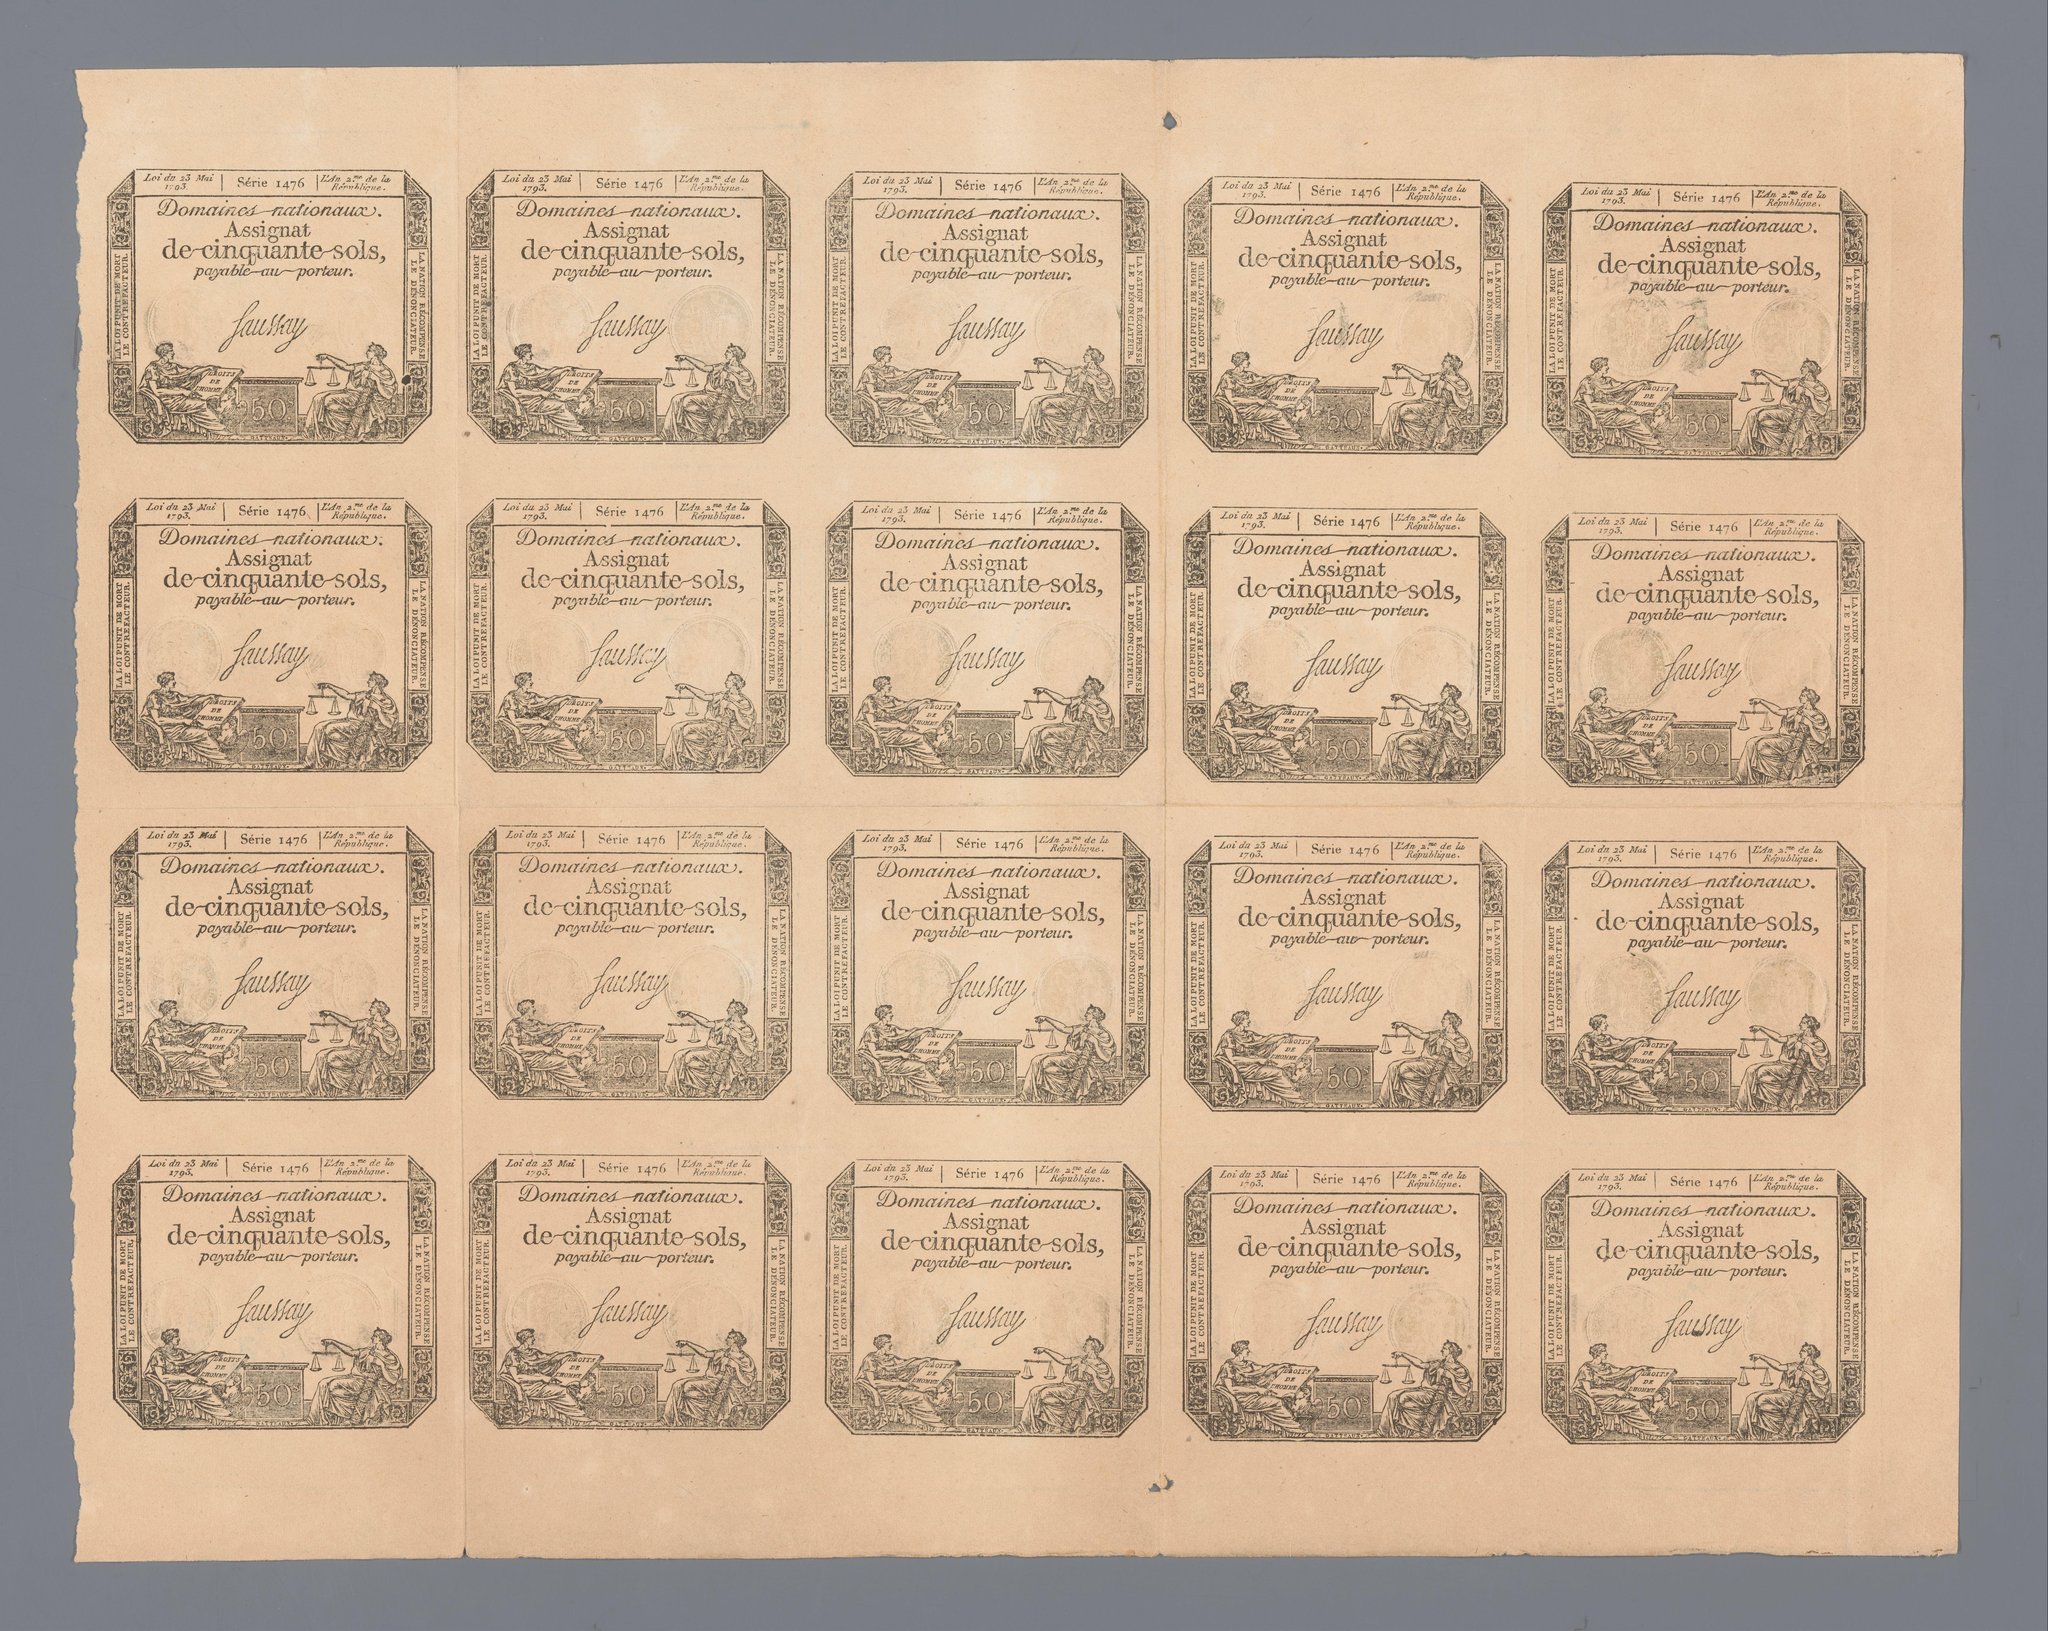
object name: assignat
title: Vel met 20 assignaten van vijftig sols, serie 1476 uitgegeven 23 mei 1793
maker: nicolas marie gatteaux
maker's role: medailleur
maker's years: 1751-1832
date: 1793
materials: paper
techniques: printing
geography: paris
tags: bank-note, france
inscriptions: signature: ‘Faussay’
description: Vel met 20 franse assignaten uit de serie 1476 à 50 sols, gesignerd door Faussay, éénzijdig bedrukt. Gesigneerd. Gedatereerd: 23-5-1793. Gemerkt: reliëfstempels (2).